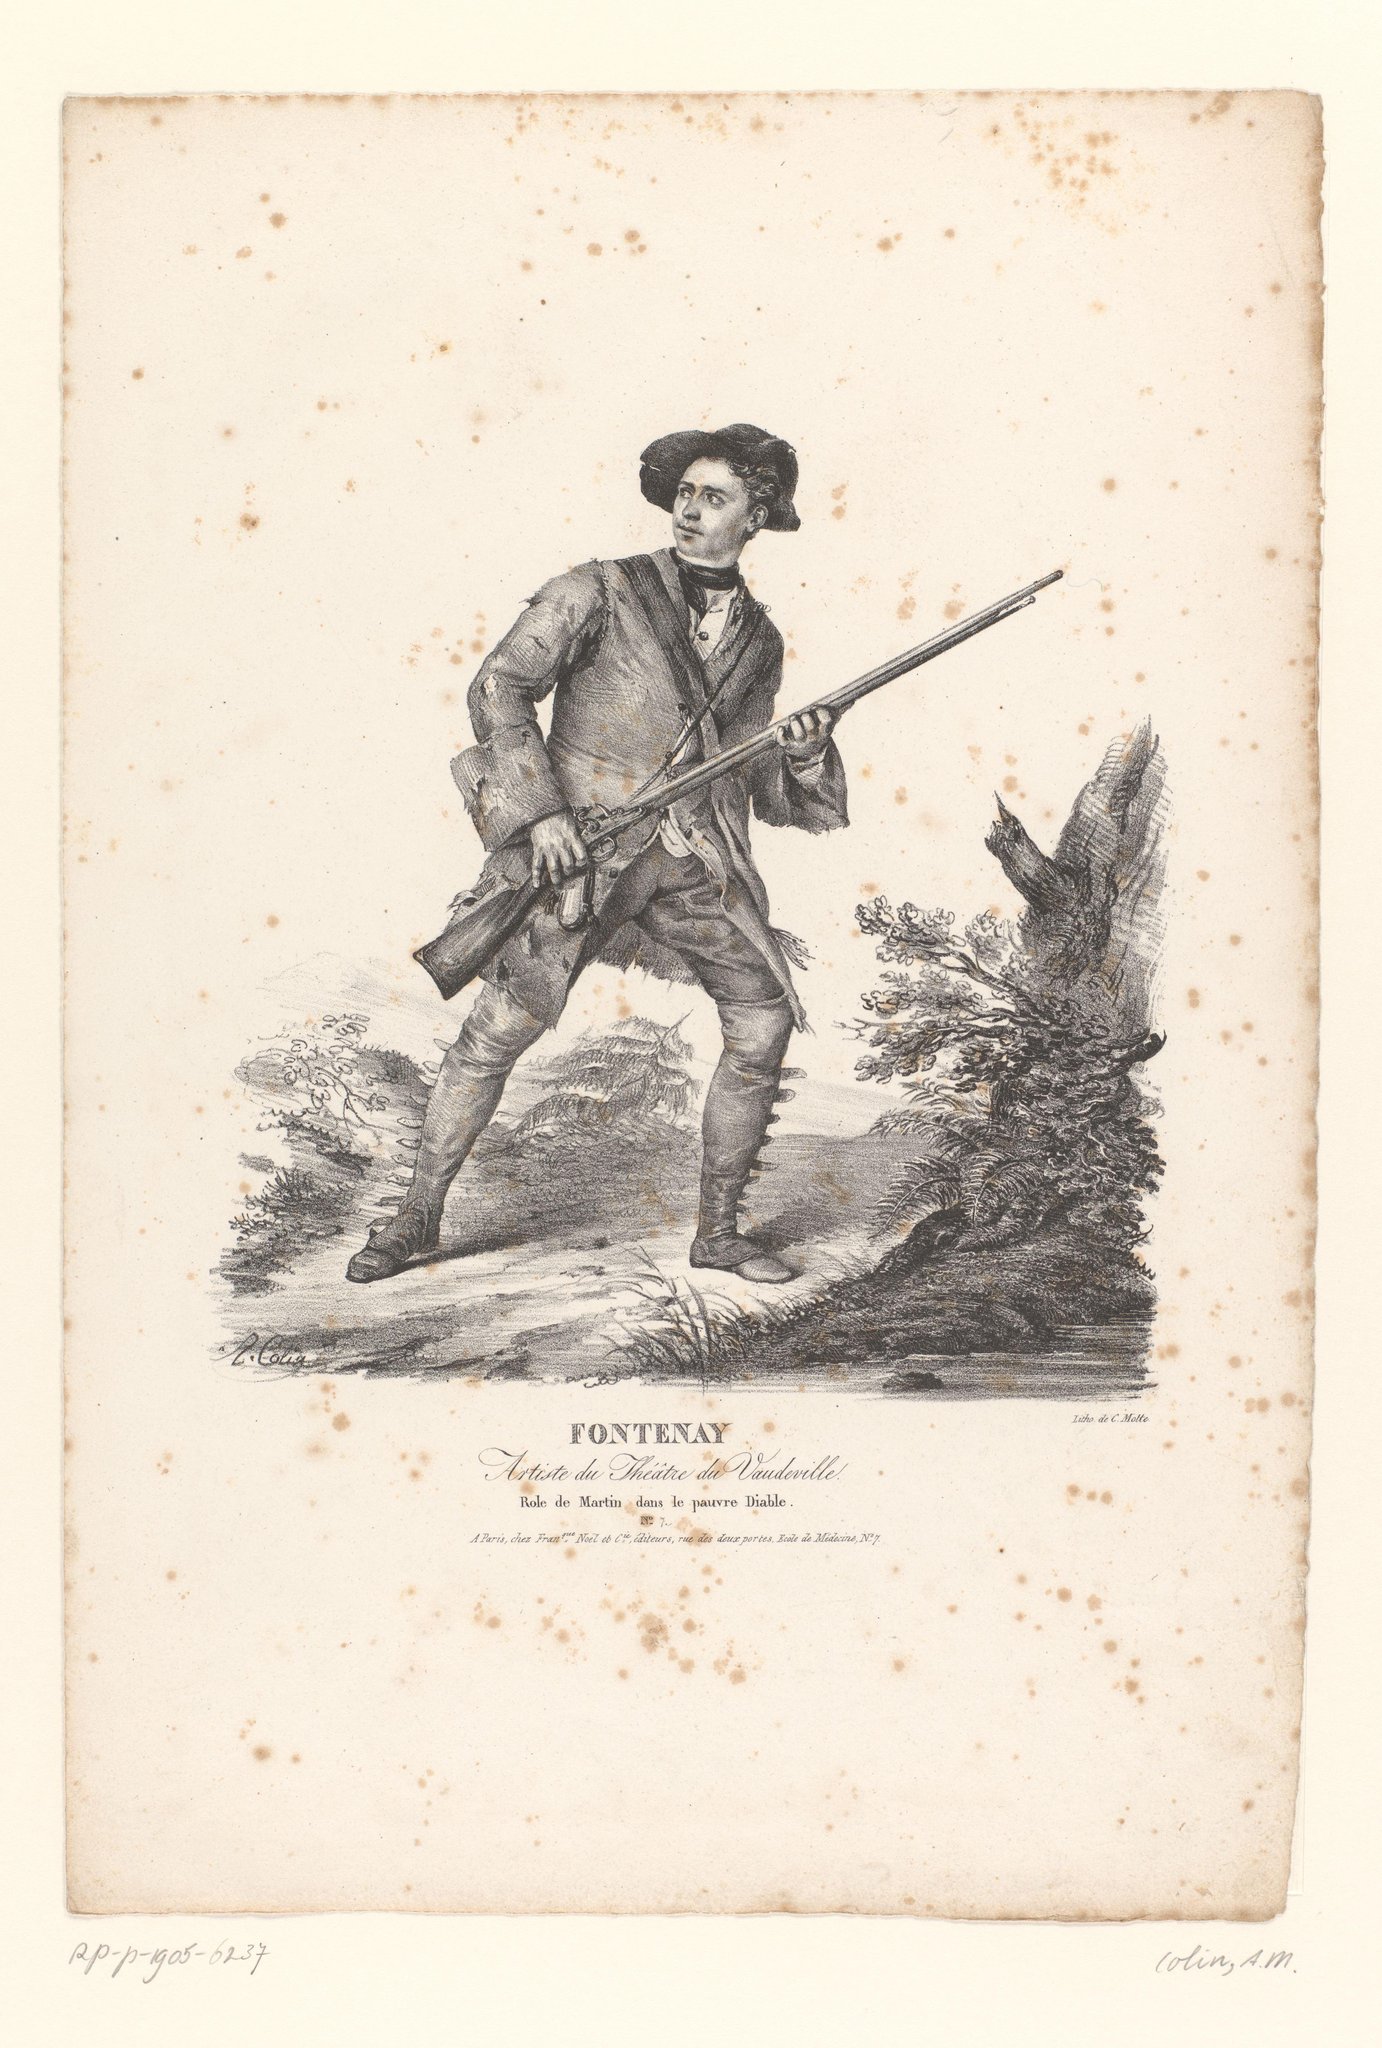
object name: print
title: Portretten van acteurs van Parijse theaters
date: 1823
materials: paper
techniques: lithograph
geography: paris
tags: stage costume, portrait of actor, actress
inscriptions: collector's mark: Lugt 2228a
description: Martin is een personage uit de vaudeville 'Le pauvre diable' of 'Un bienfait n'est jamais perdu', geschreven door Balisson de Rougemont en Théophile Dumersan. Opgevoerd door het Théâtre du Vaudeville in Parijs in 1808.